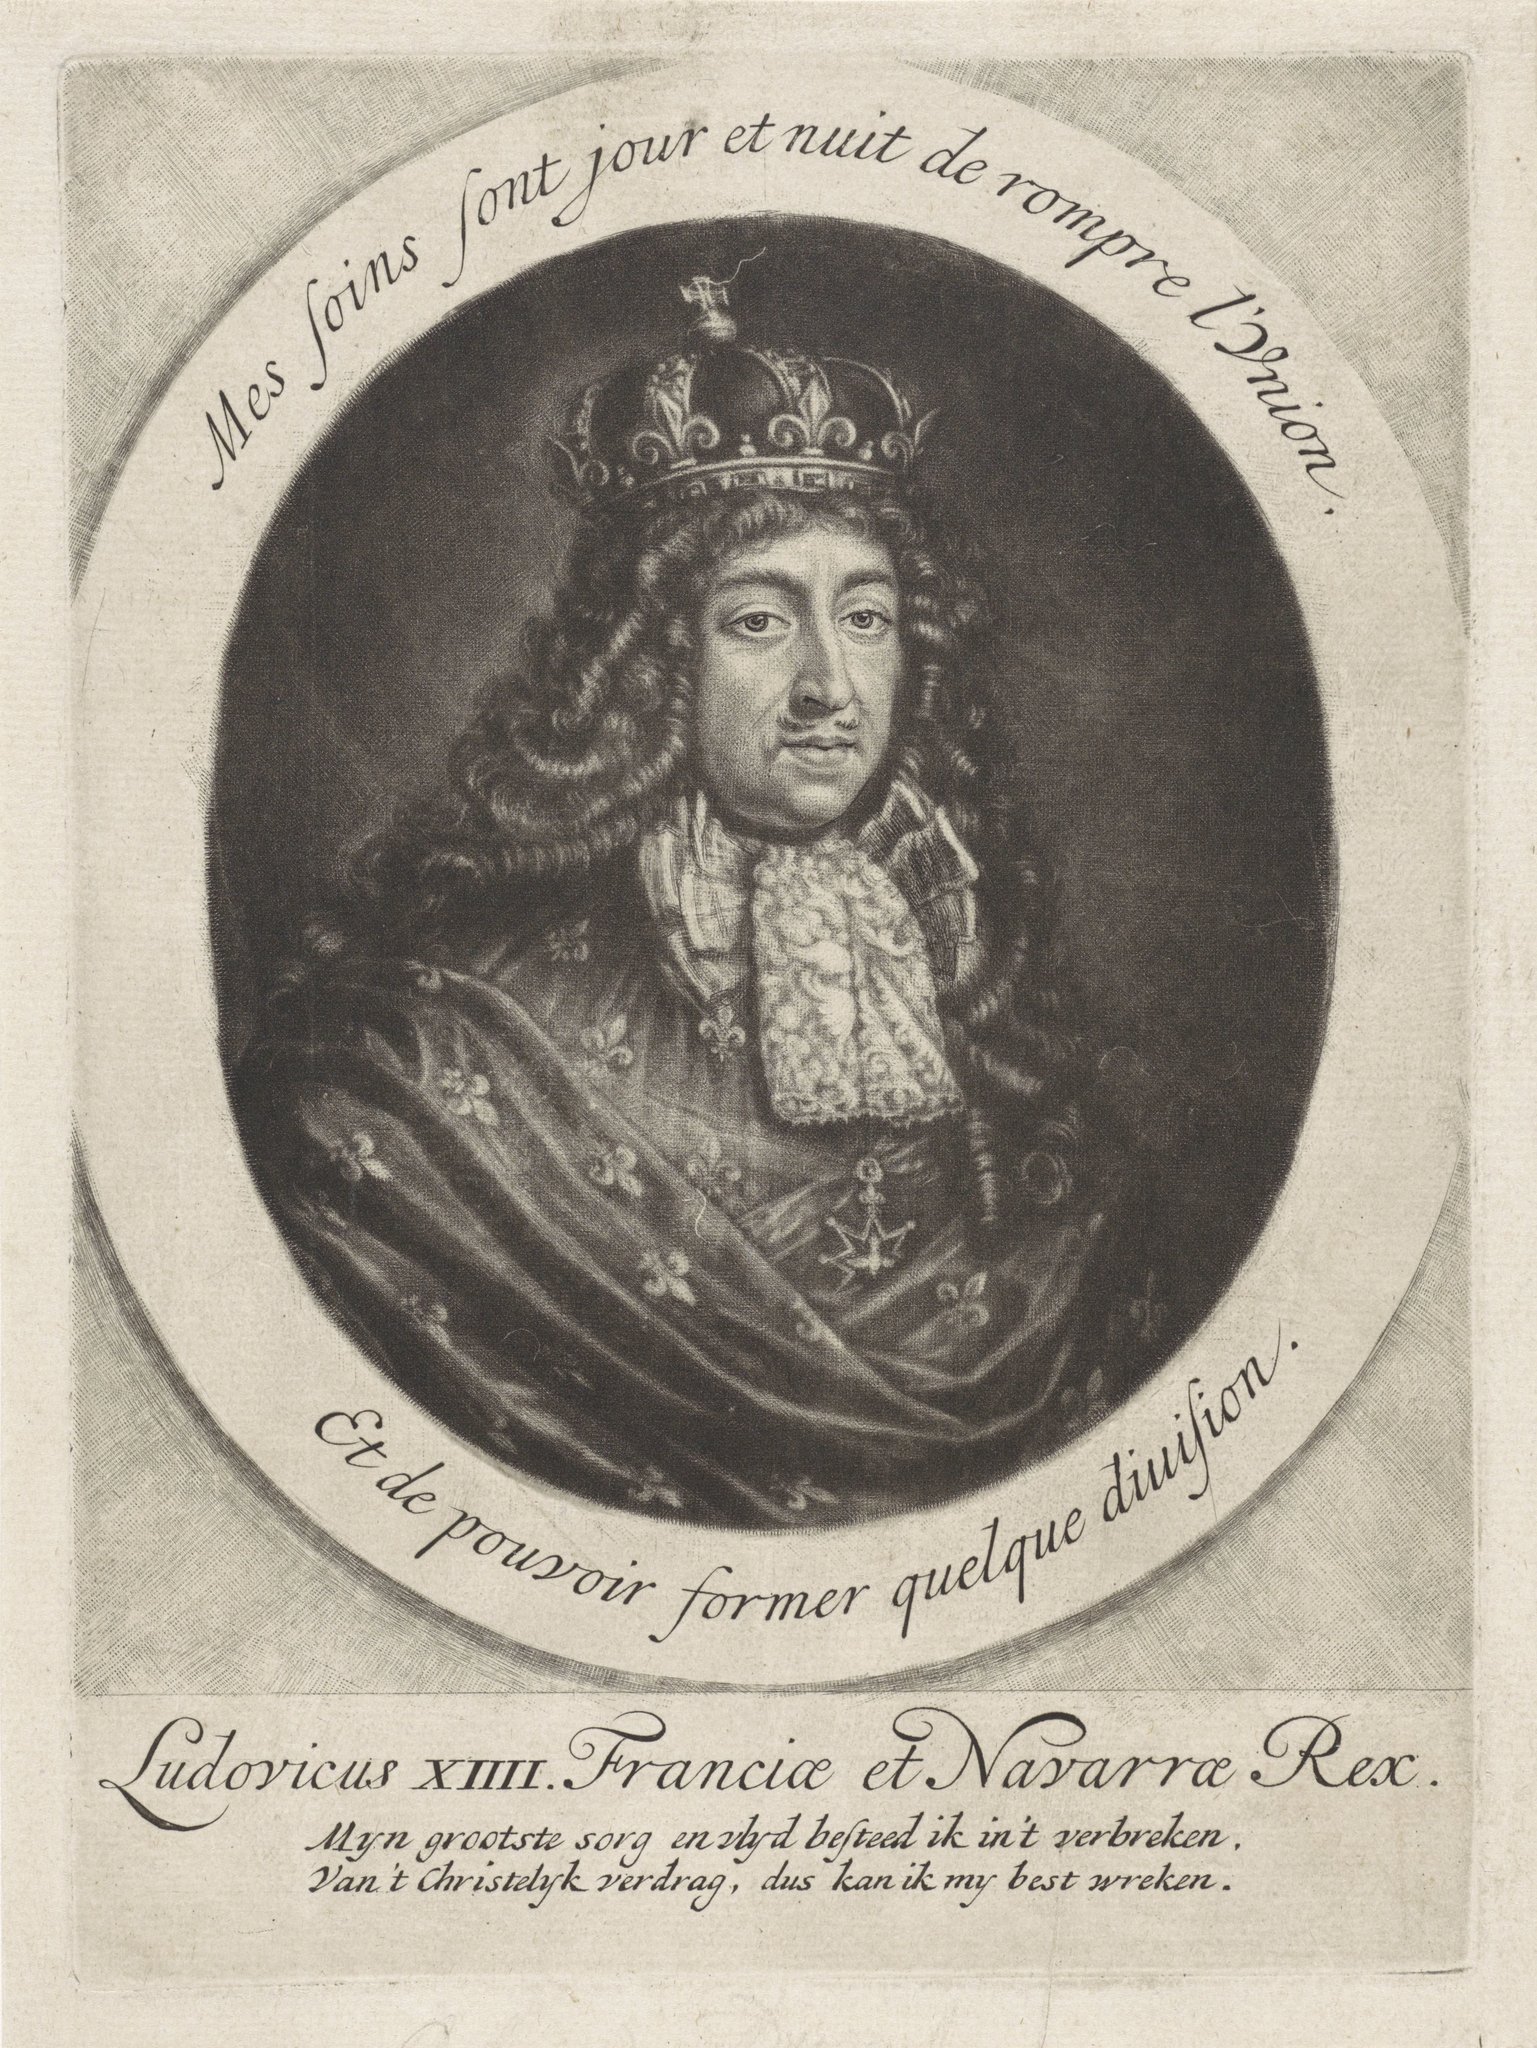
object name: print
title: Portret van Lodewijk XIV, koning van Frankrijk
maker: jacob gole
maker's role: print maker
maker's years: 1660-1724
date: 1670-1724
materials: paper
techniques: engraving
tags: lodewijk xiv (koning van frankrijk), crown (symbol of sovereignty), fleur-de-lis ~ ornament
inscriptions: collector's mark: Lugt 2228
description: Lodewijk XIV, koning van Frankrijk, in een mantel bezaaid met Franse lelies. Op het hoofd de koningskroon.